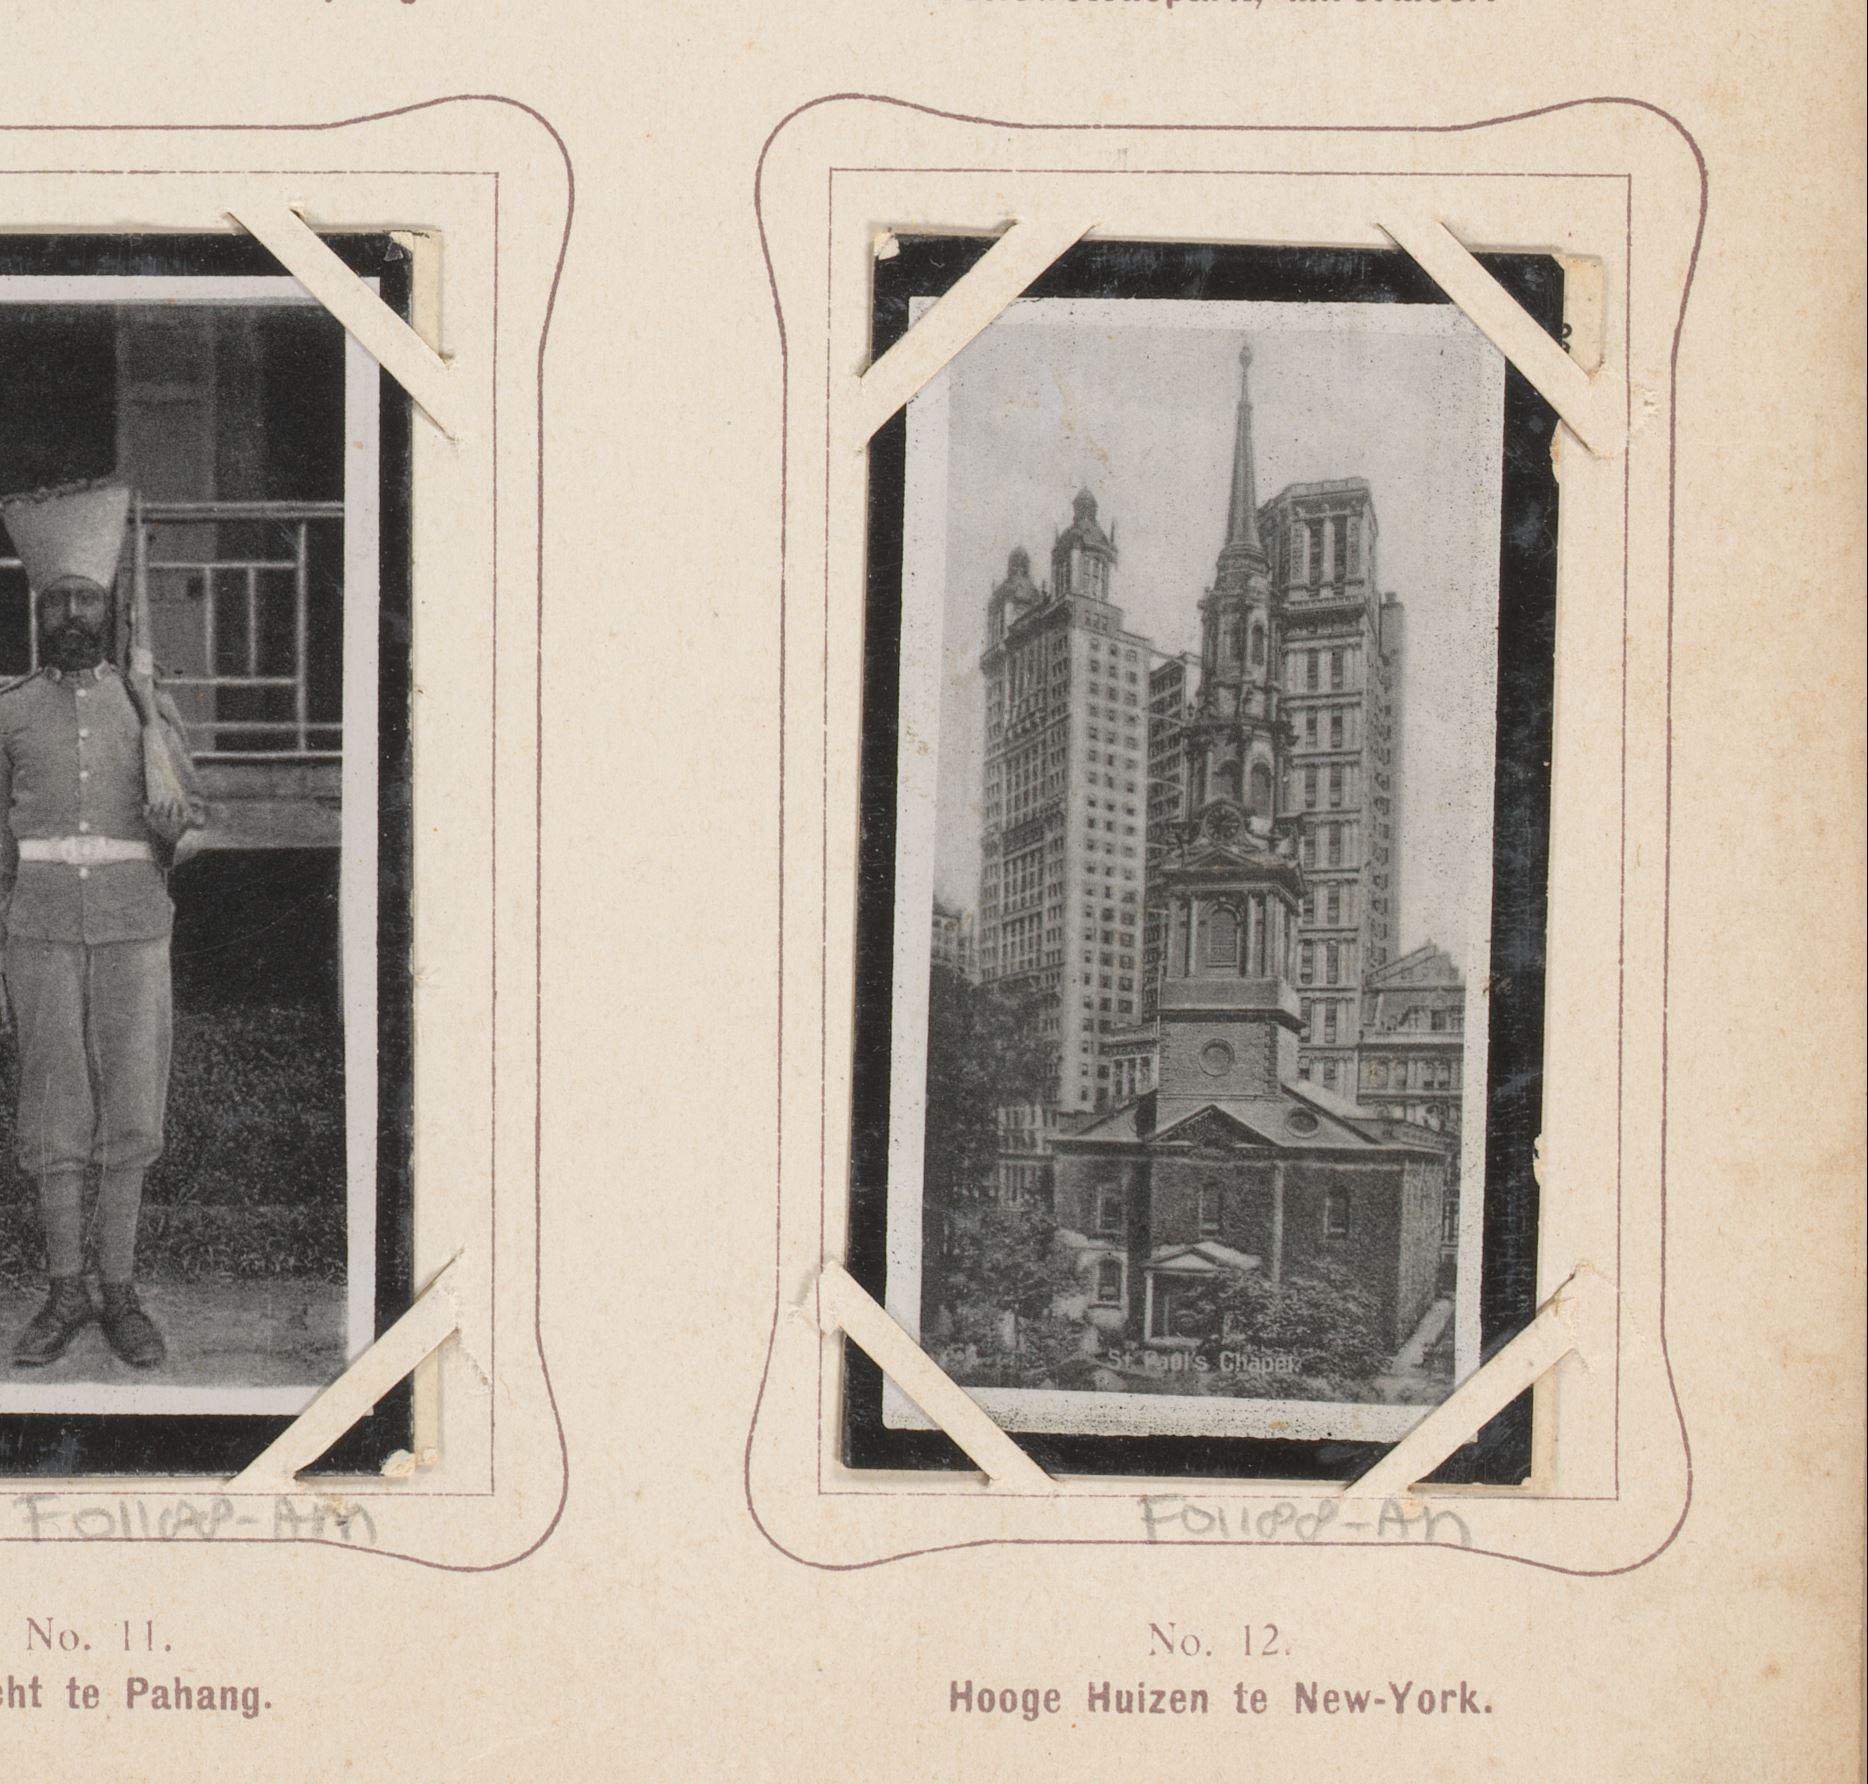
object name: photomechanical print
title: Gezicht op St. Paul's Chapel met woontorens te New York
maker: Anonymous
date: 1906-1907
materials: paper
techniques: photograph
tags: urban housing, church (exterior)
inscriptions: inscription: ‘No. 12./ Hooge Huize te New-York.’, inscription: ‘St. Paul's Chapel’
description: Deze prent maakt deel uit van een album.